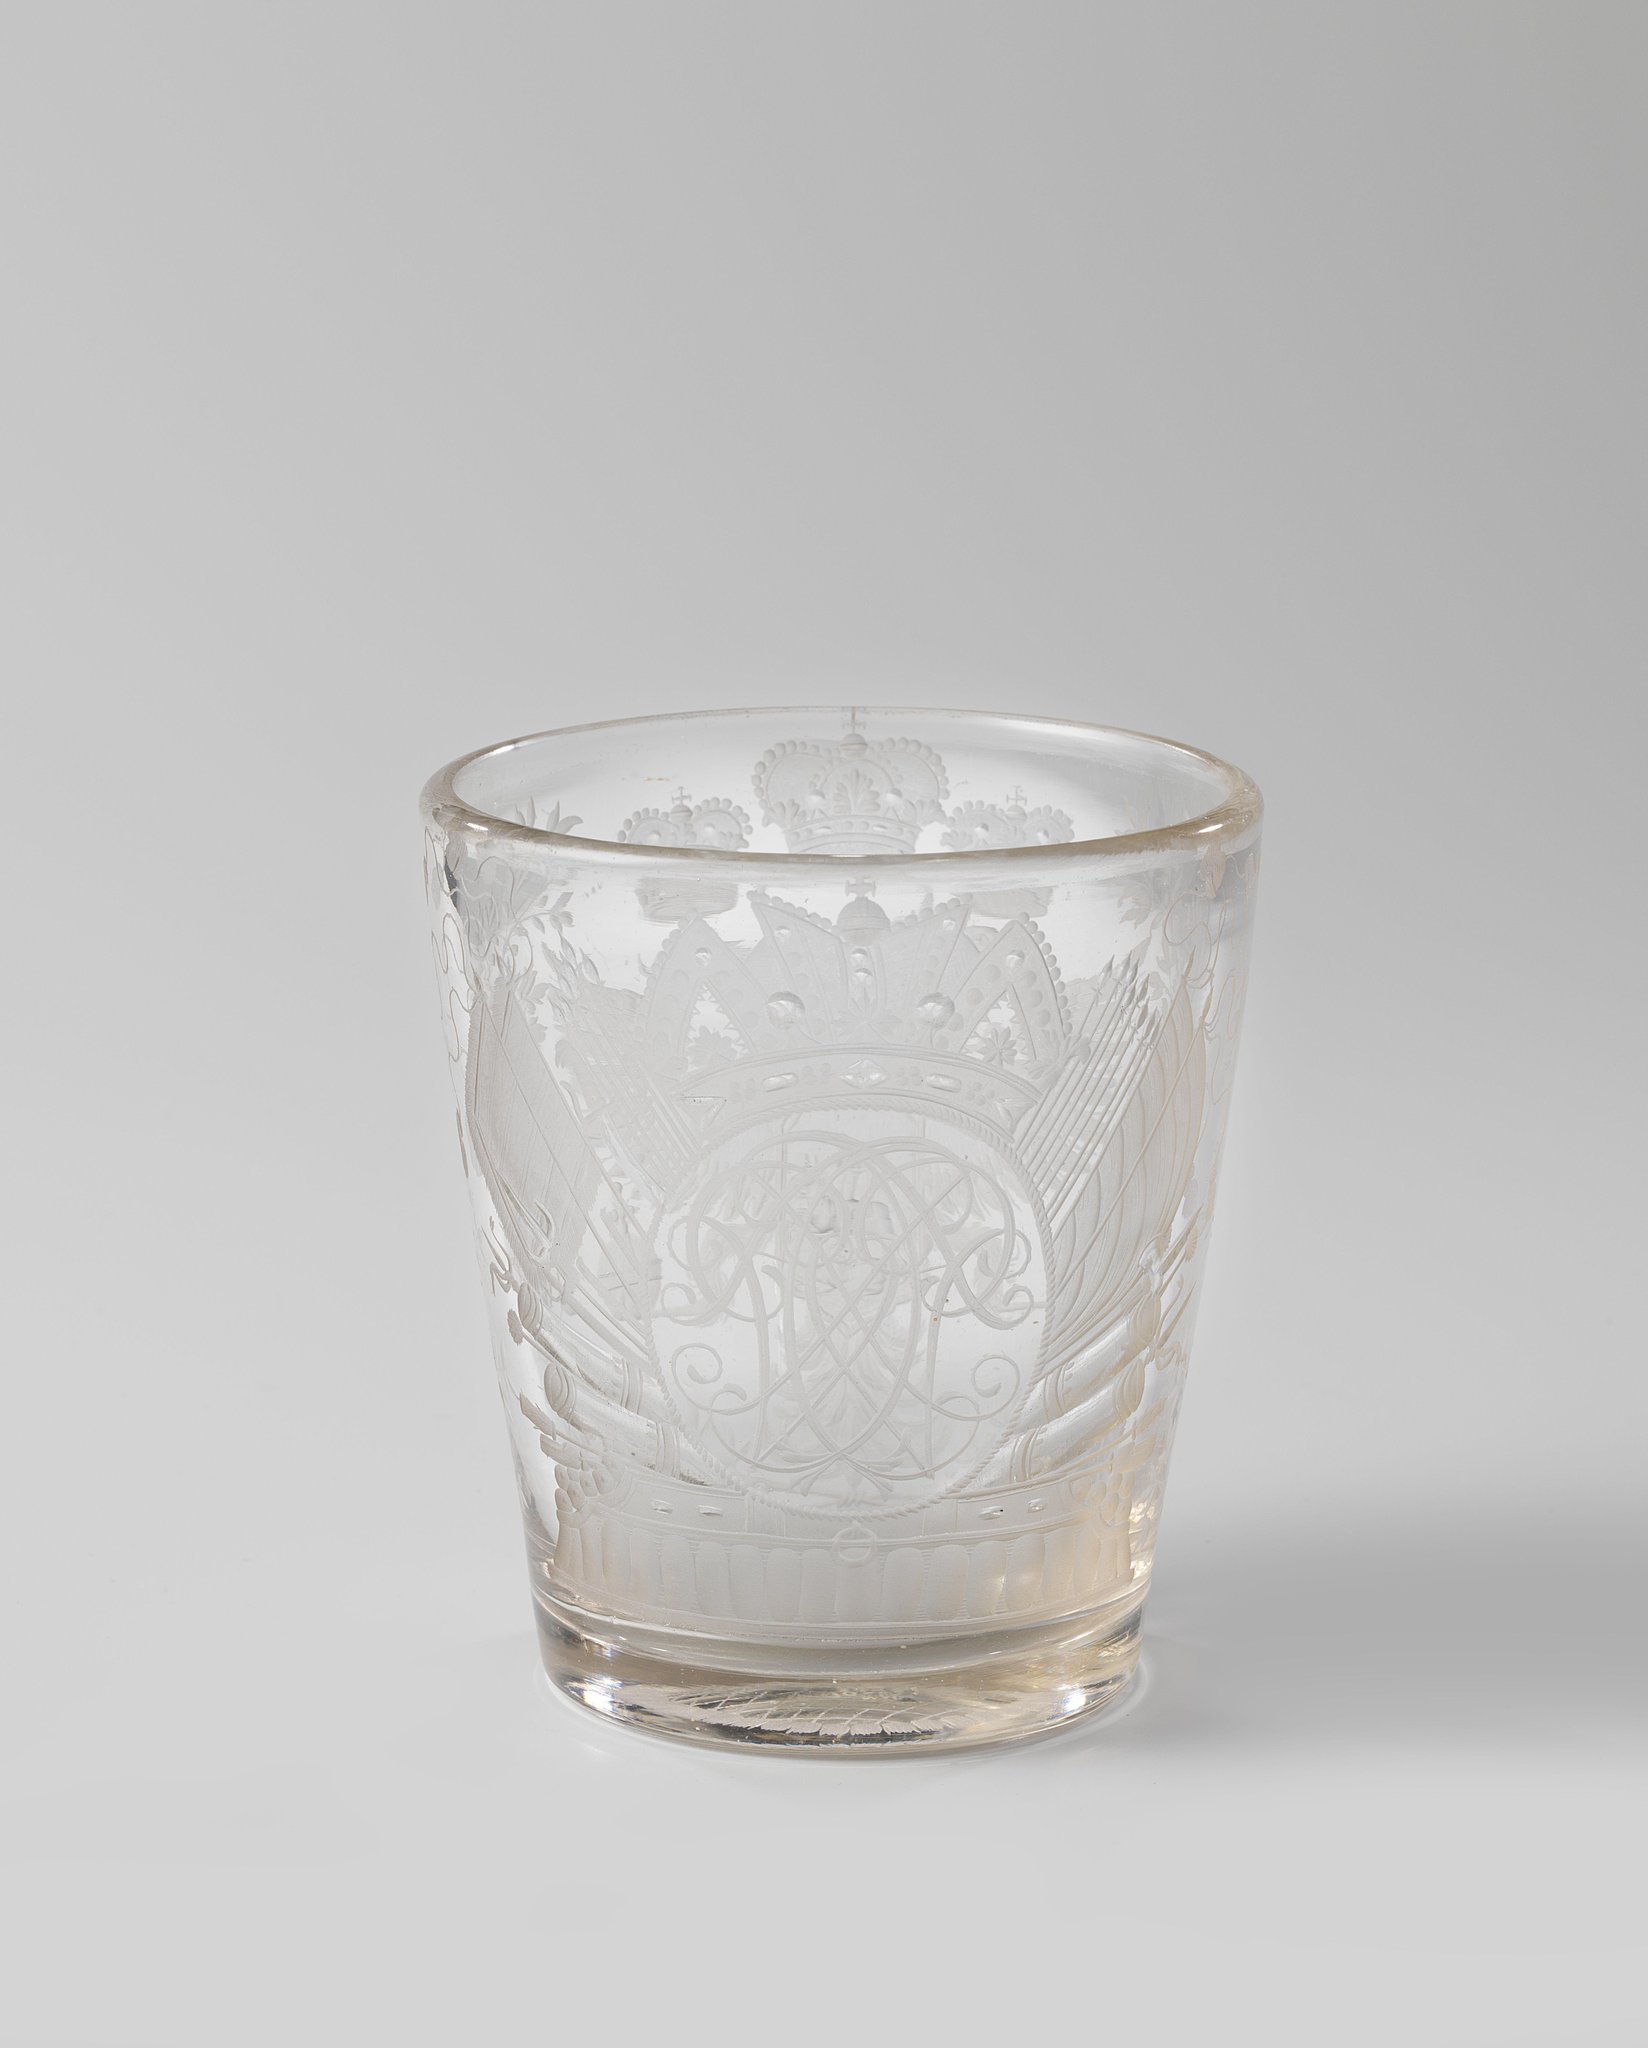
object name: cup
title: Beker met gekroonde Russische adelaar en het wapen en het monogram van tsaar Peter de Grote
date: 1721-1725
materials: glass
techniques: glassblowing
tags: peter i de grote (tsaar van rusland)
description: Beaker. Wheel engraving with the coat of arms of Tsar Peter the Great (1672 - 1725). Germany, c. 1700 - 1725. A.J. Enschedé bequest, 1896.